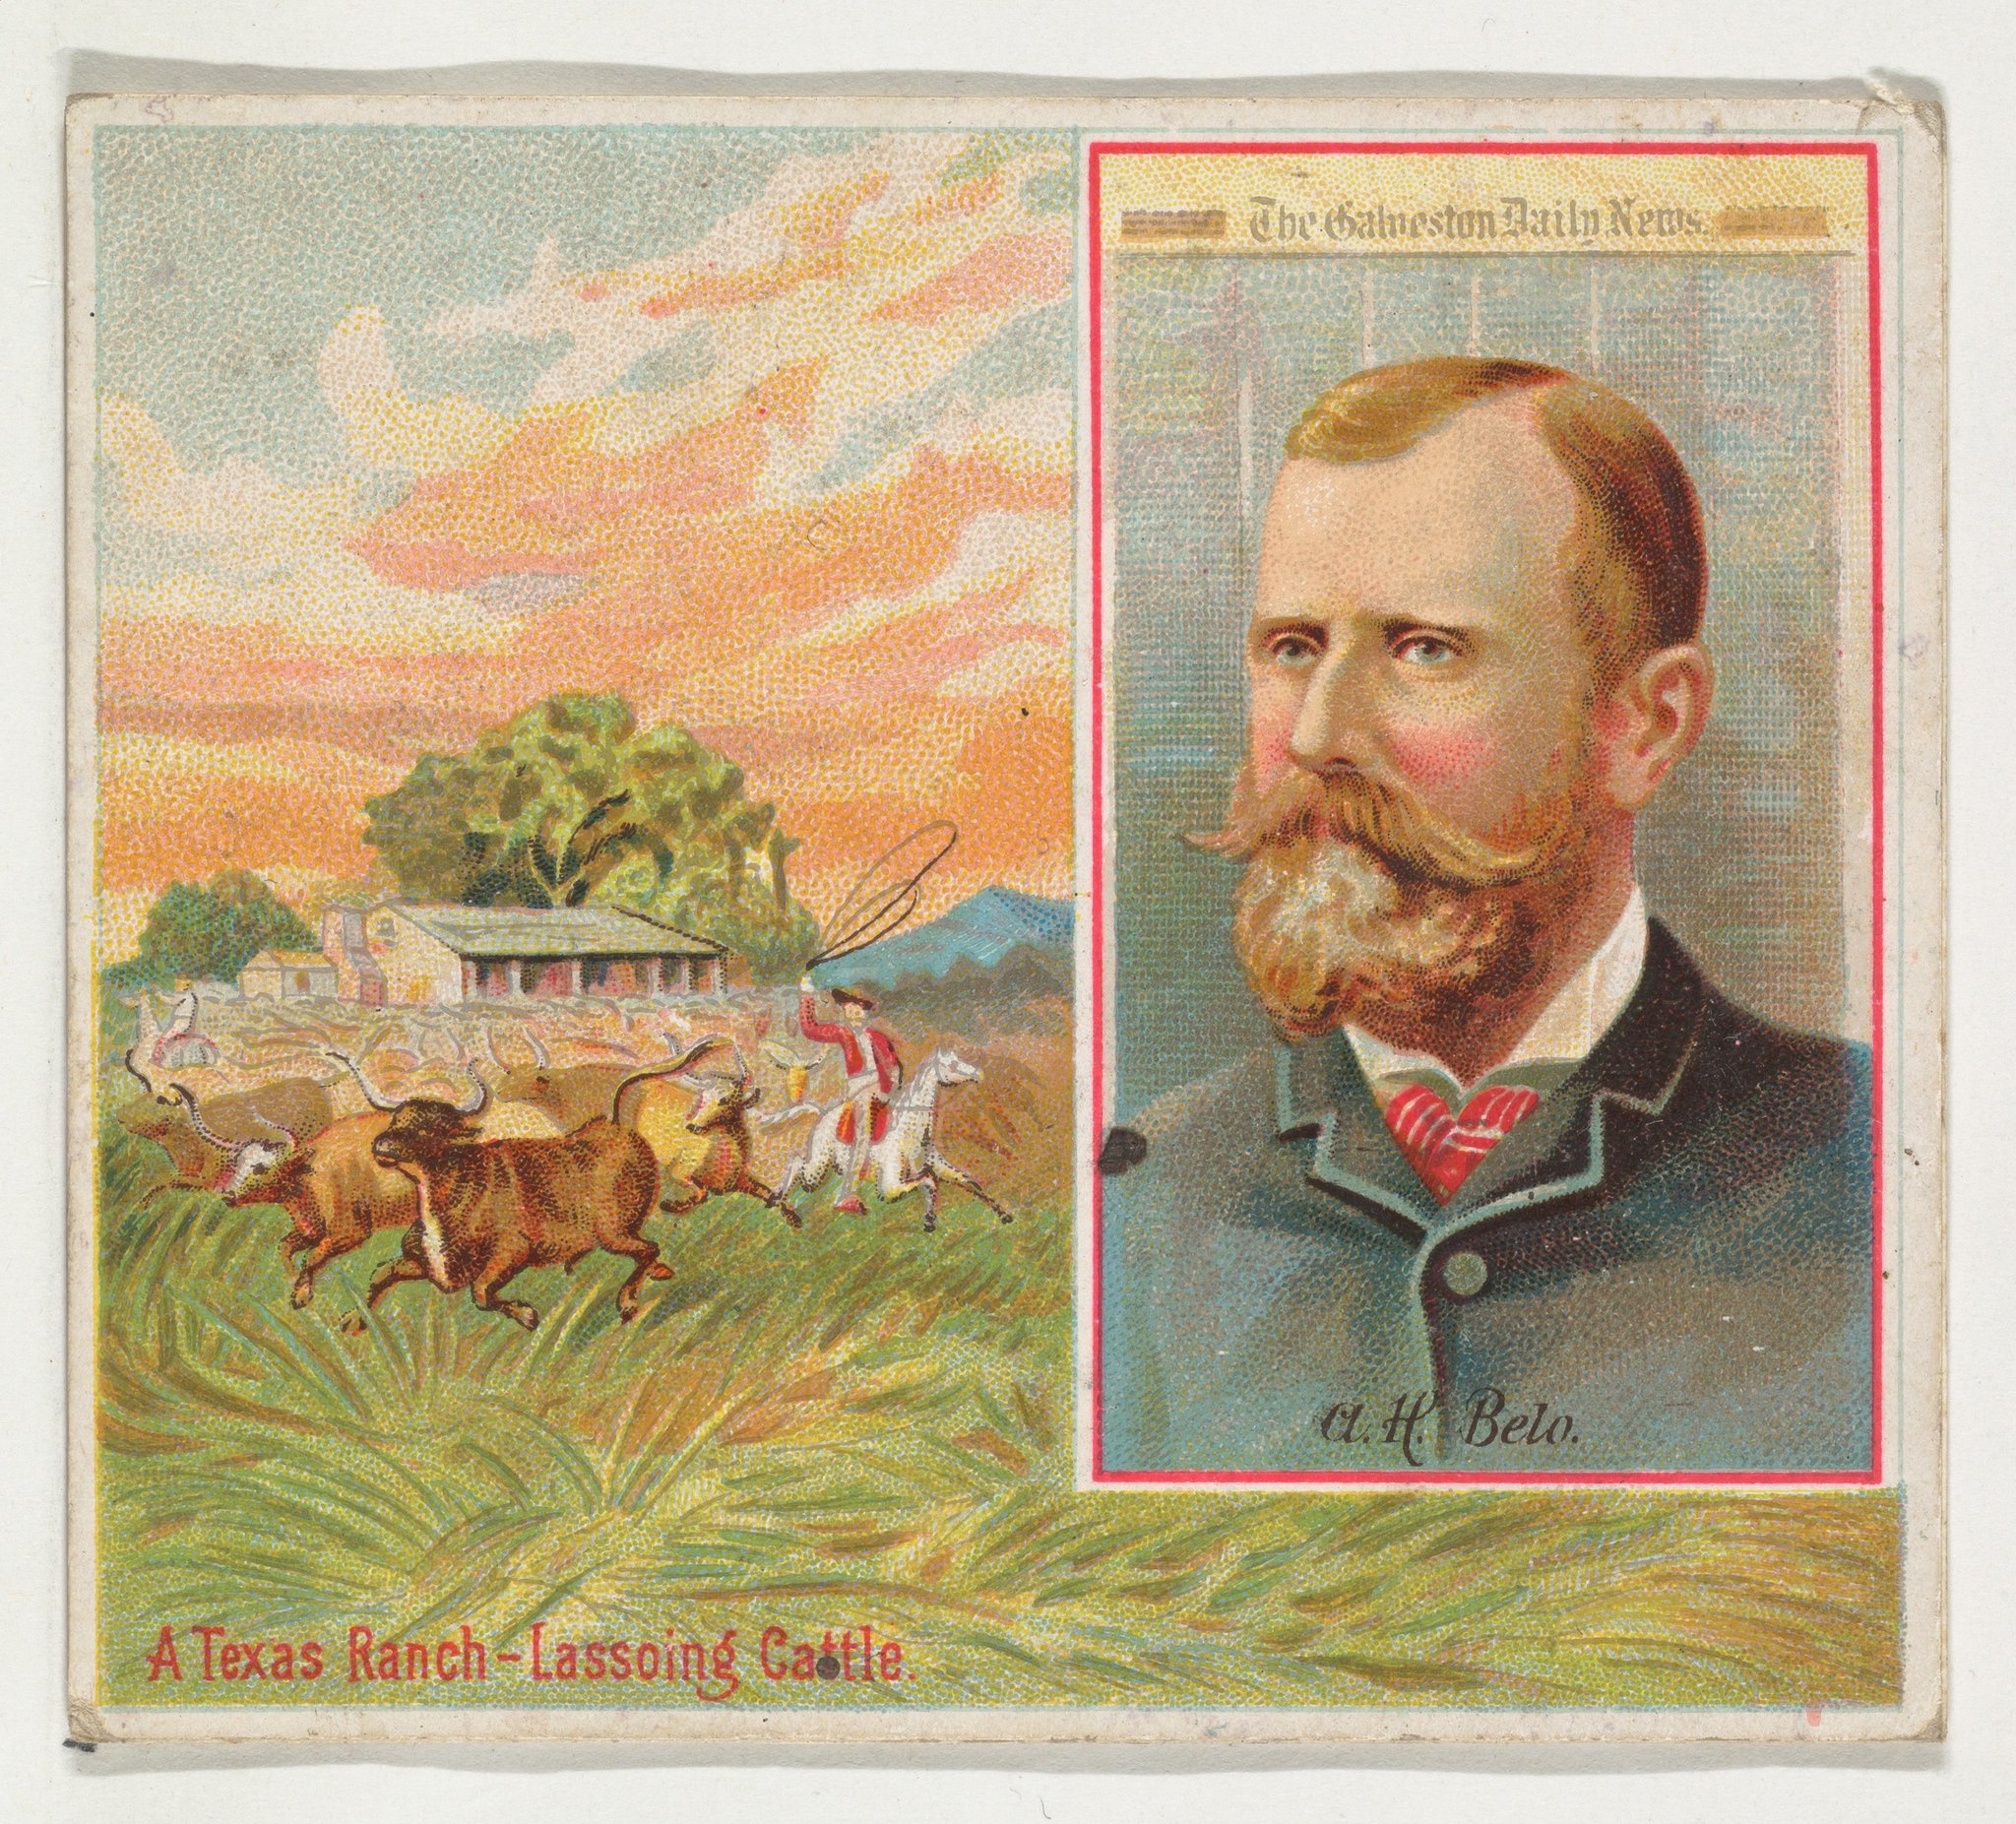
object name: print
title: A.H. Belo, The Galveston Daily News, from the American Editors series (N35) for Allen & Ginter Cigarettes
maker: allen & ginter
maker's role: publisher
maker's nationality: american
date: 1887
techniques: color lithograph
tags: men,profiles,bulls,horses